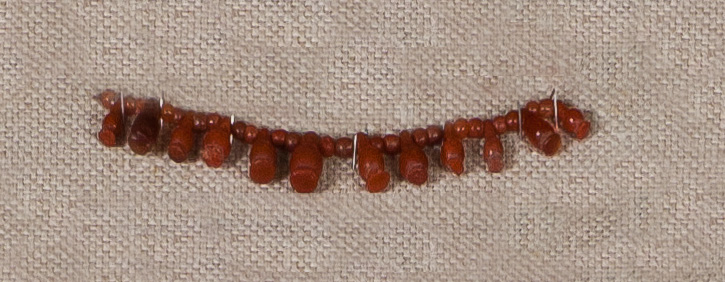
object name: necklace, bead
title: String of Carnelian Beads and Poppy Pendants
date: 1981-1295 BCE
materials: gemstone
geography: egypt